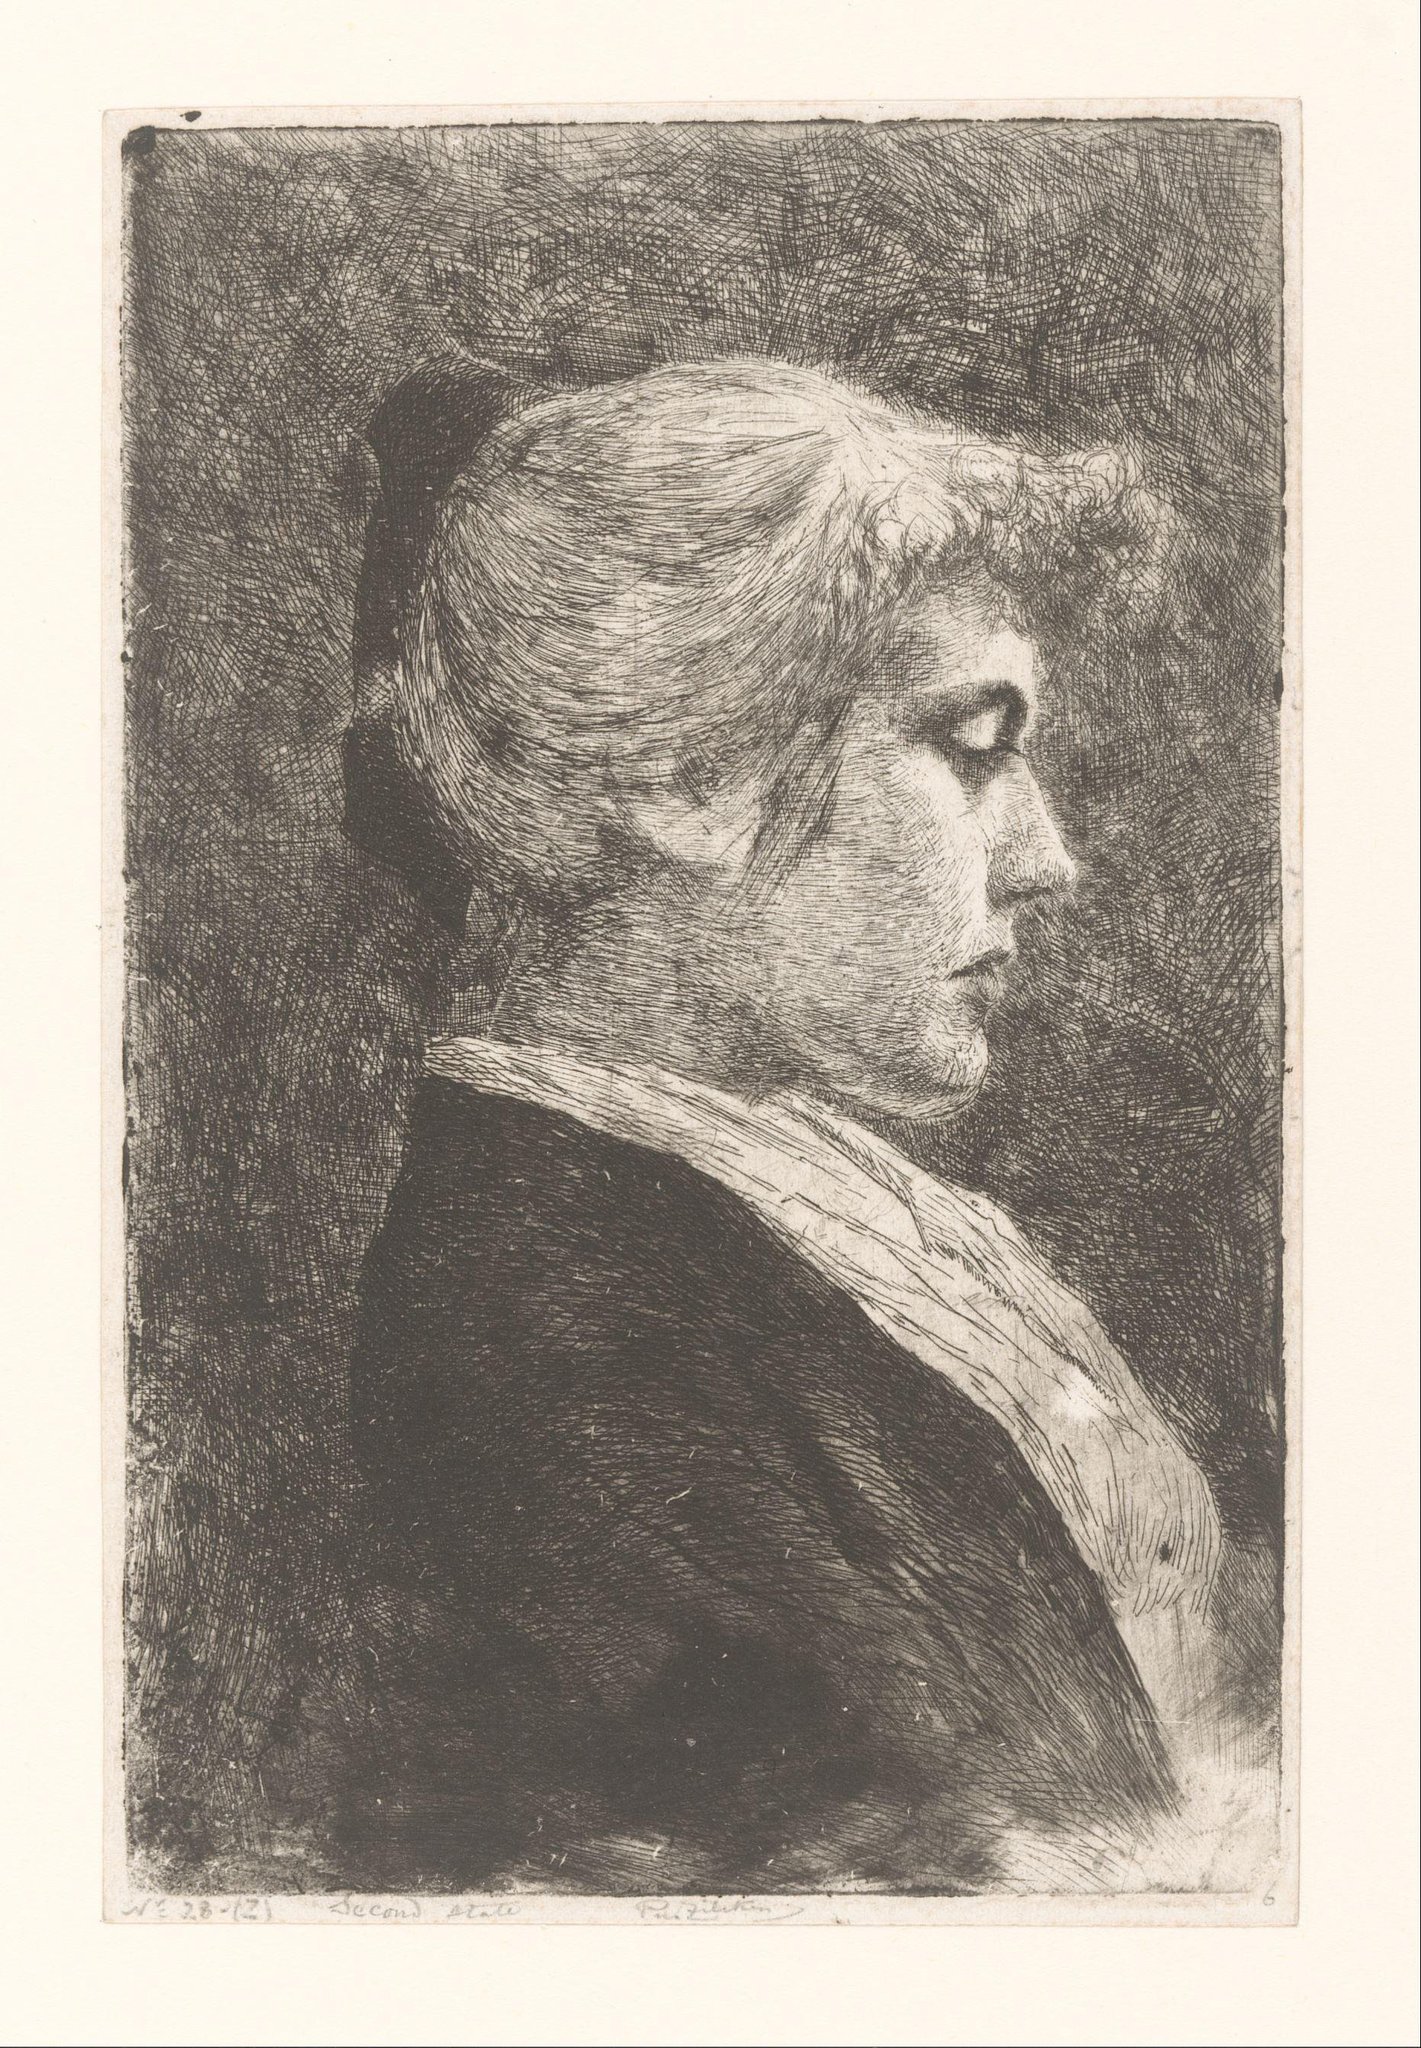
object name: print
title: Portret van een vrouw, en profil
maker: philip zilcken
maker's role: draughtsman, painter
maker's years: 1857-1930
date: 1867-1890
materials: paper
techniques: drypoint, etching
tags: adult woman, historical persons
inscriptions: collector's mark: Lugt 2228